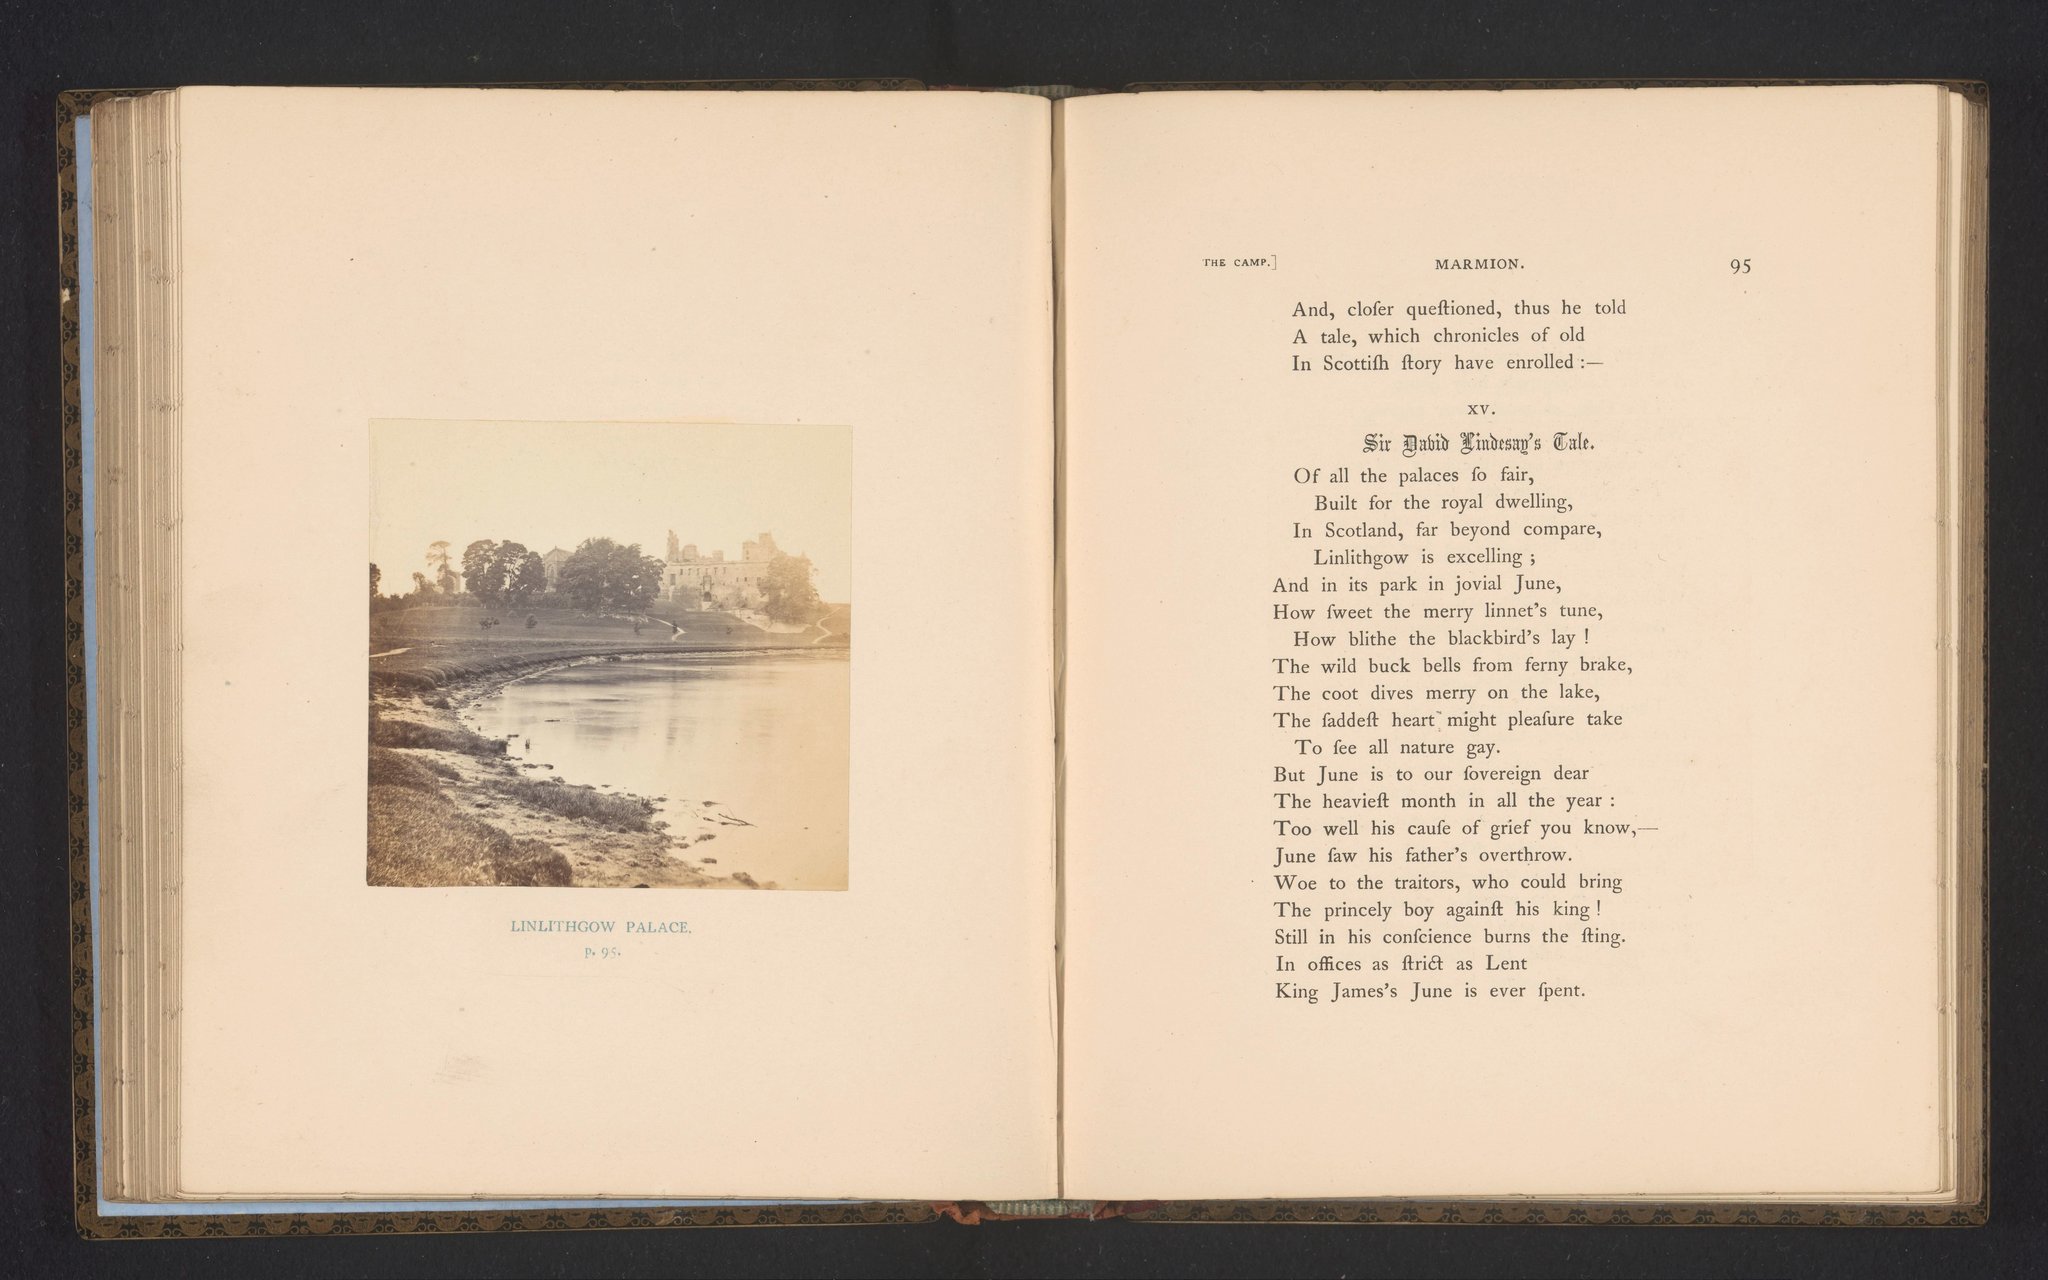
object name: page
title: Linlithgow Palace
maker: thomas annan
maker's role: fotograaf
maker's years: 1829-1887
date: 1856-1866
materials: photographic support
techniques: albumen print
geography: west lothian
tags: river, landscape with tower or castle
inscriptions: inscription: ‘p. 95.’